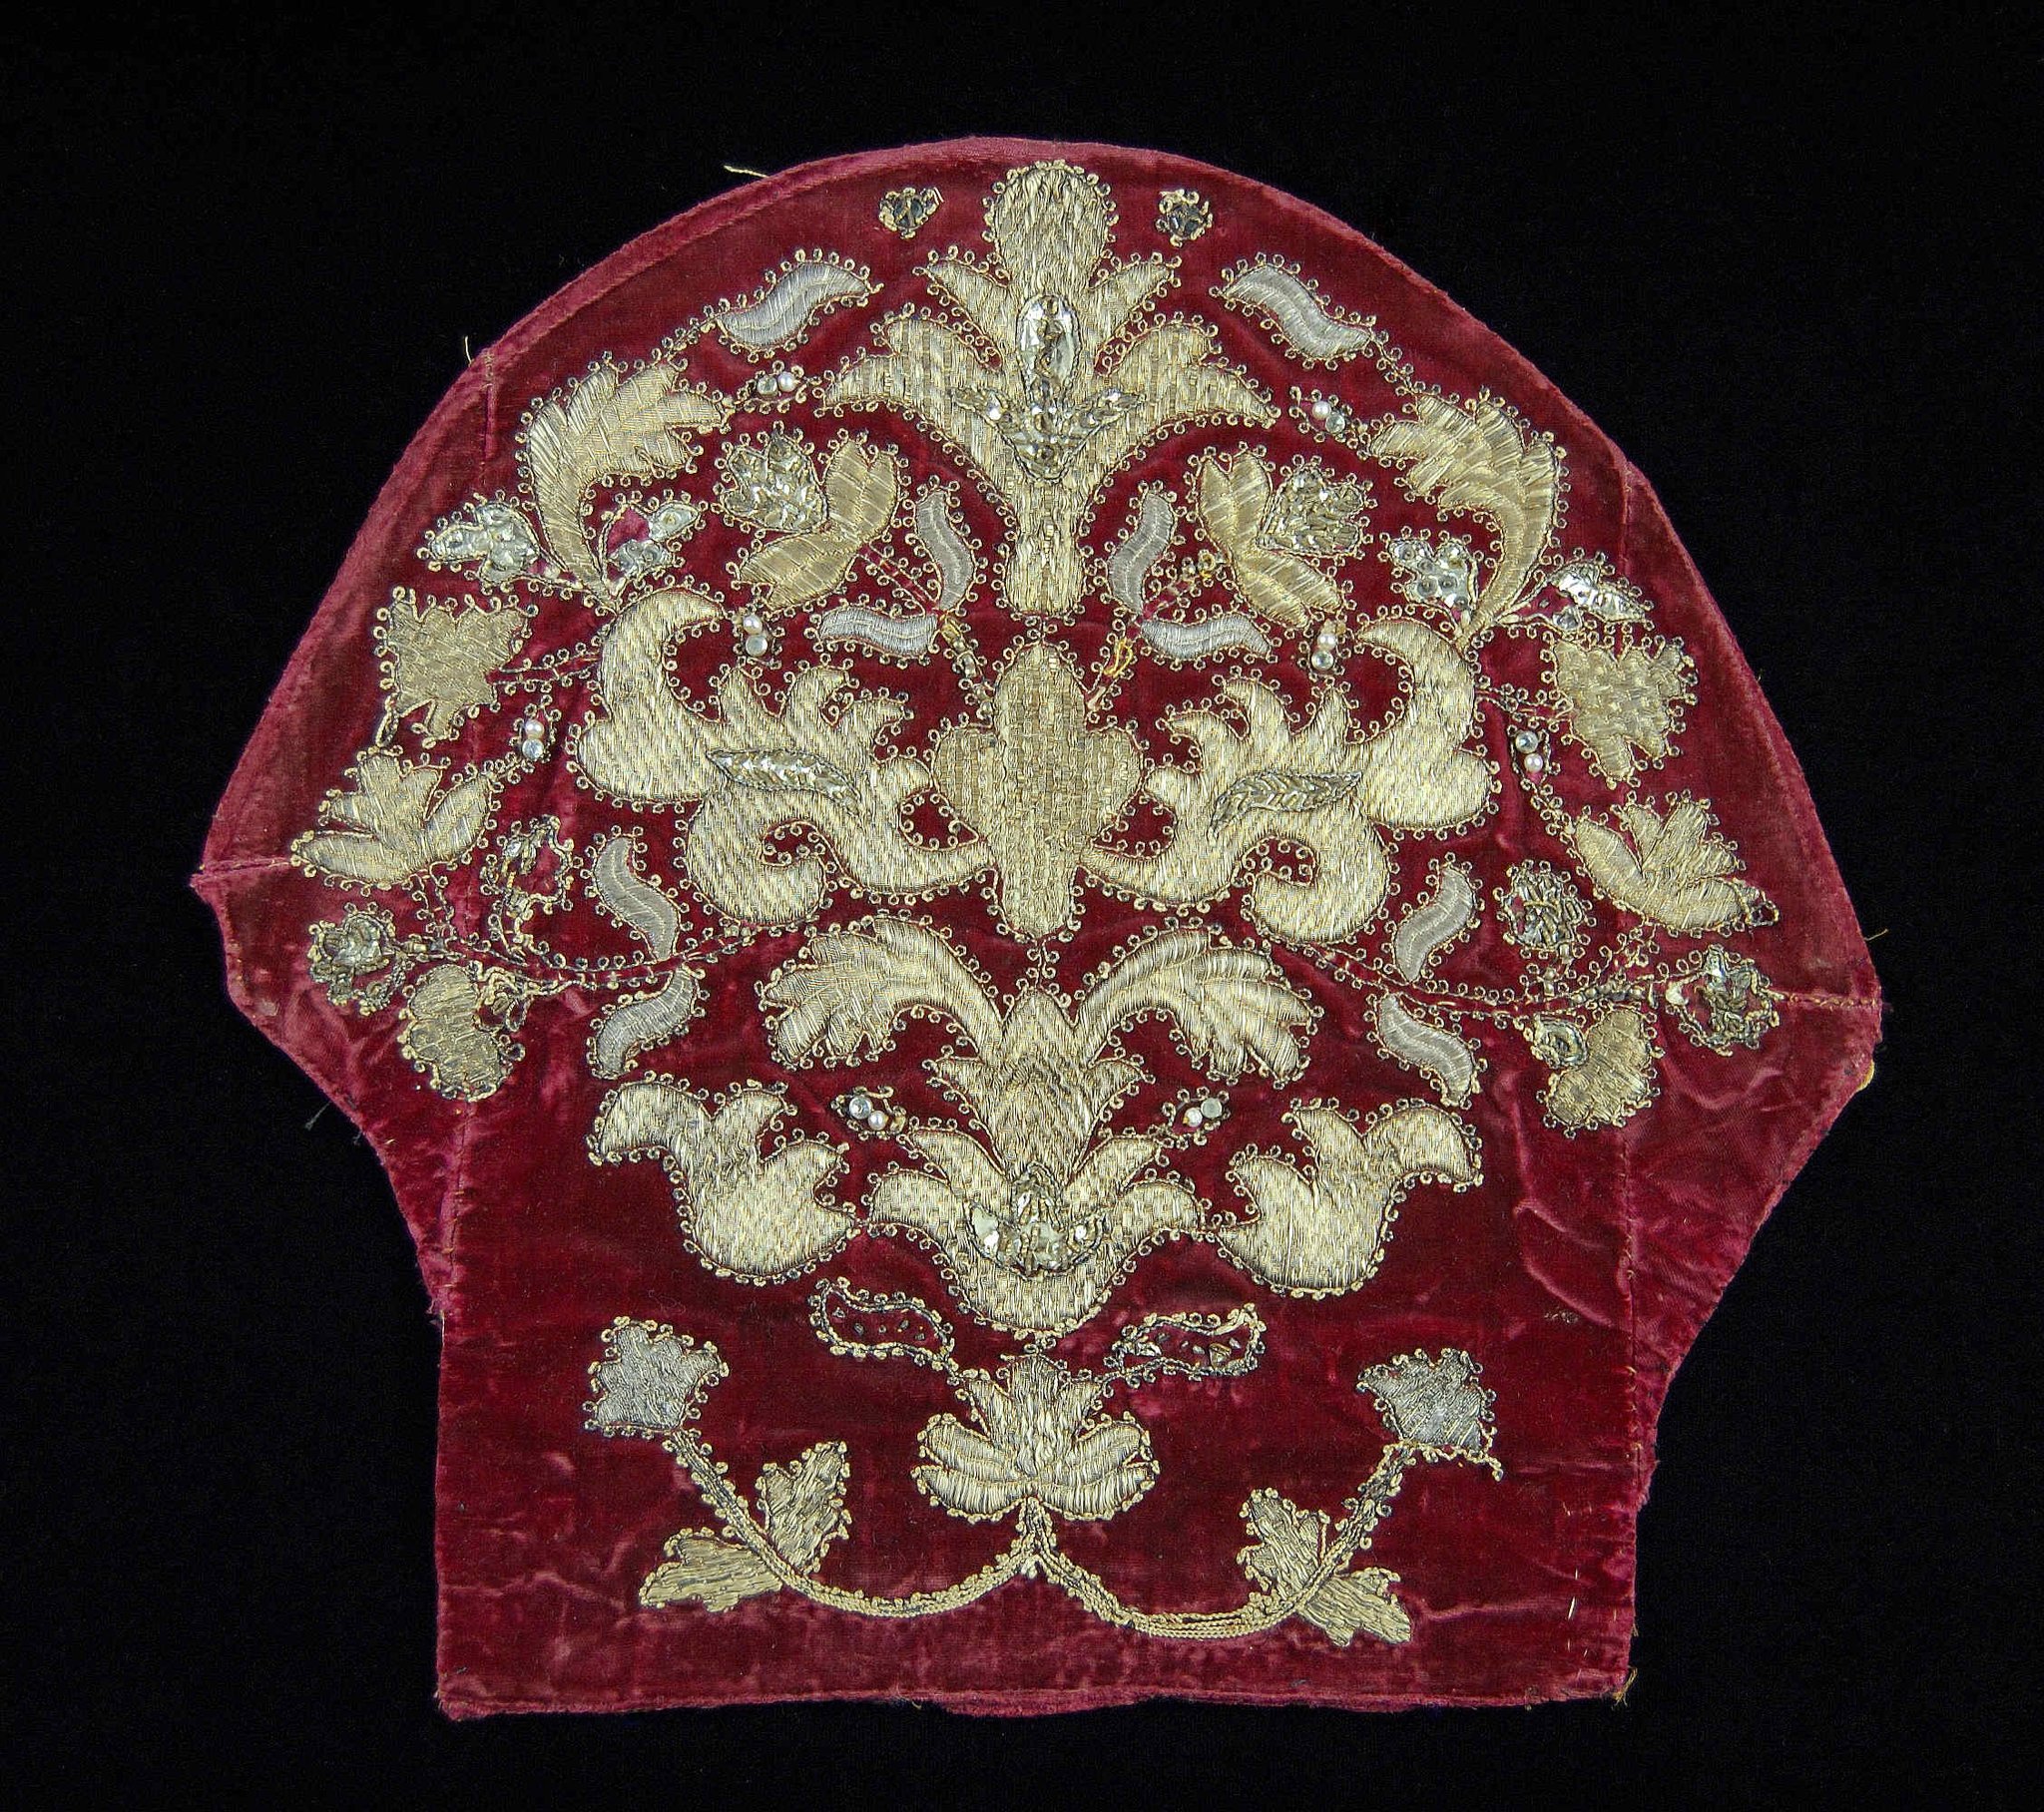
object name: headdress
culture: russian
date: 1801-1900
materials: linen, metal, pearl, silk